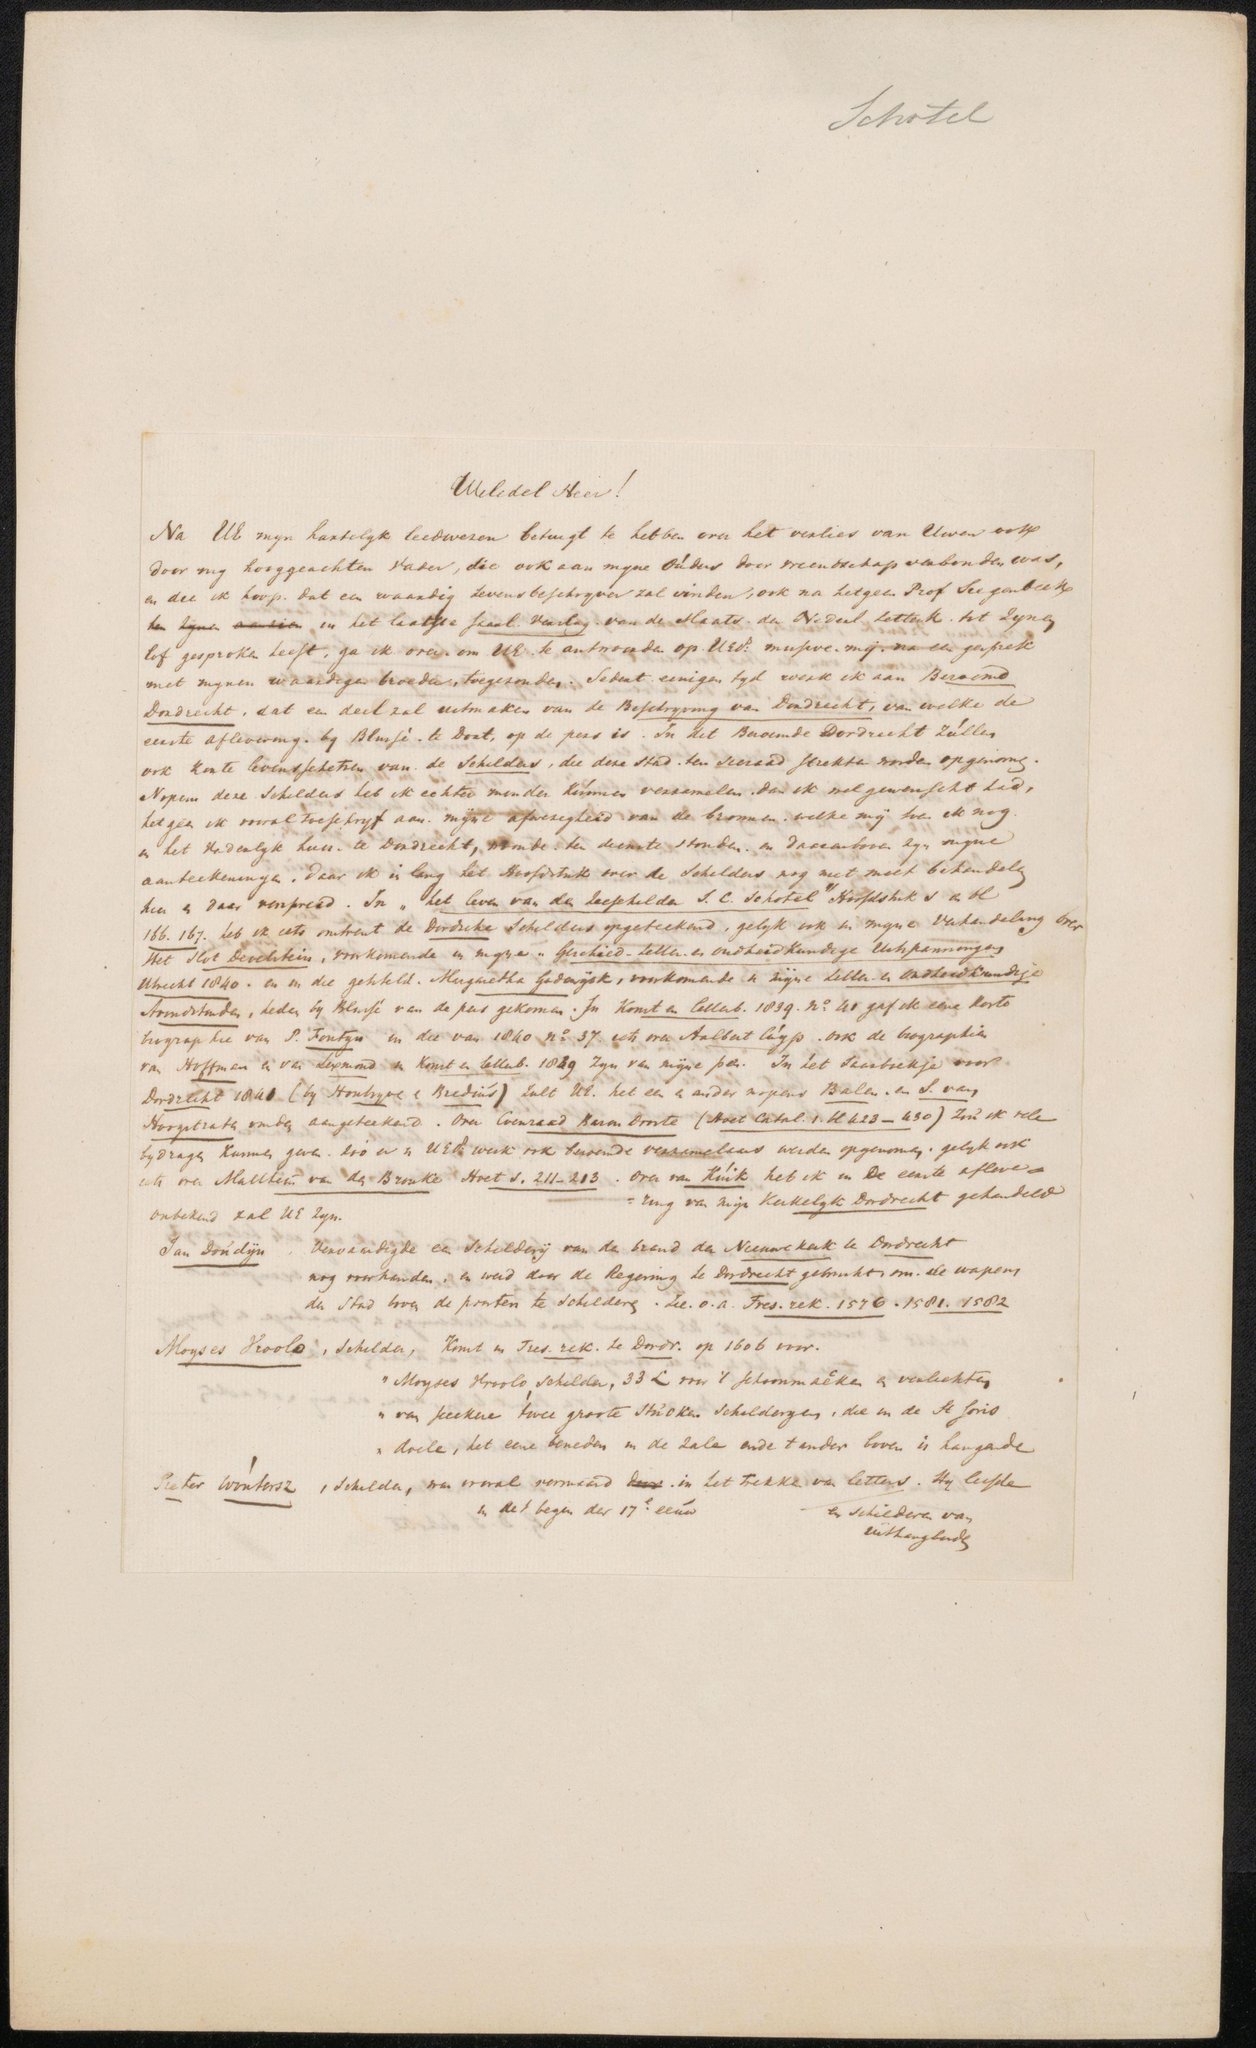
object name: letter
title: Brief aan Christiaan Immerzeel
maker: gilles dionysius jacobus schotel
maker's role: schrijver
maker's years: 1807-1892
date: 1841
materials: ink, paper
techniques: pen, writing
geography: chaam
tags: publisher, johannes immerzeel, the hague, christiaan immerzeel, painting (including book-illumination, miniature-painting), printed matter, dordrecht